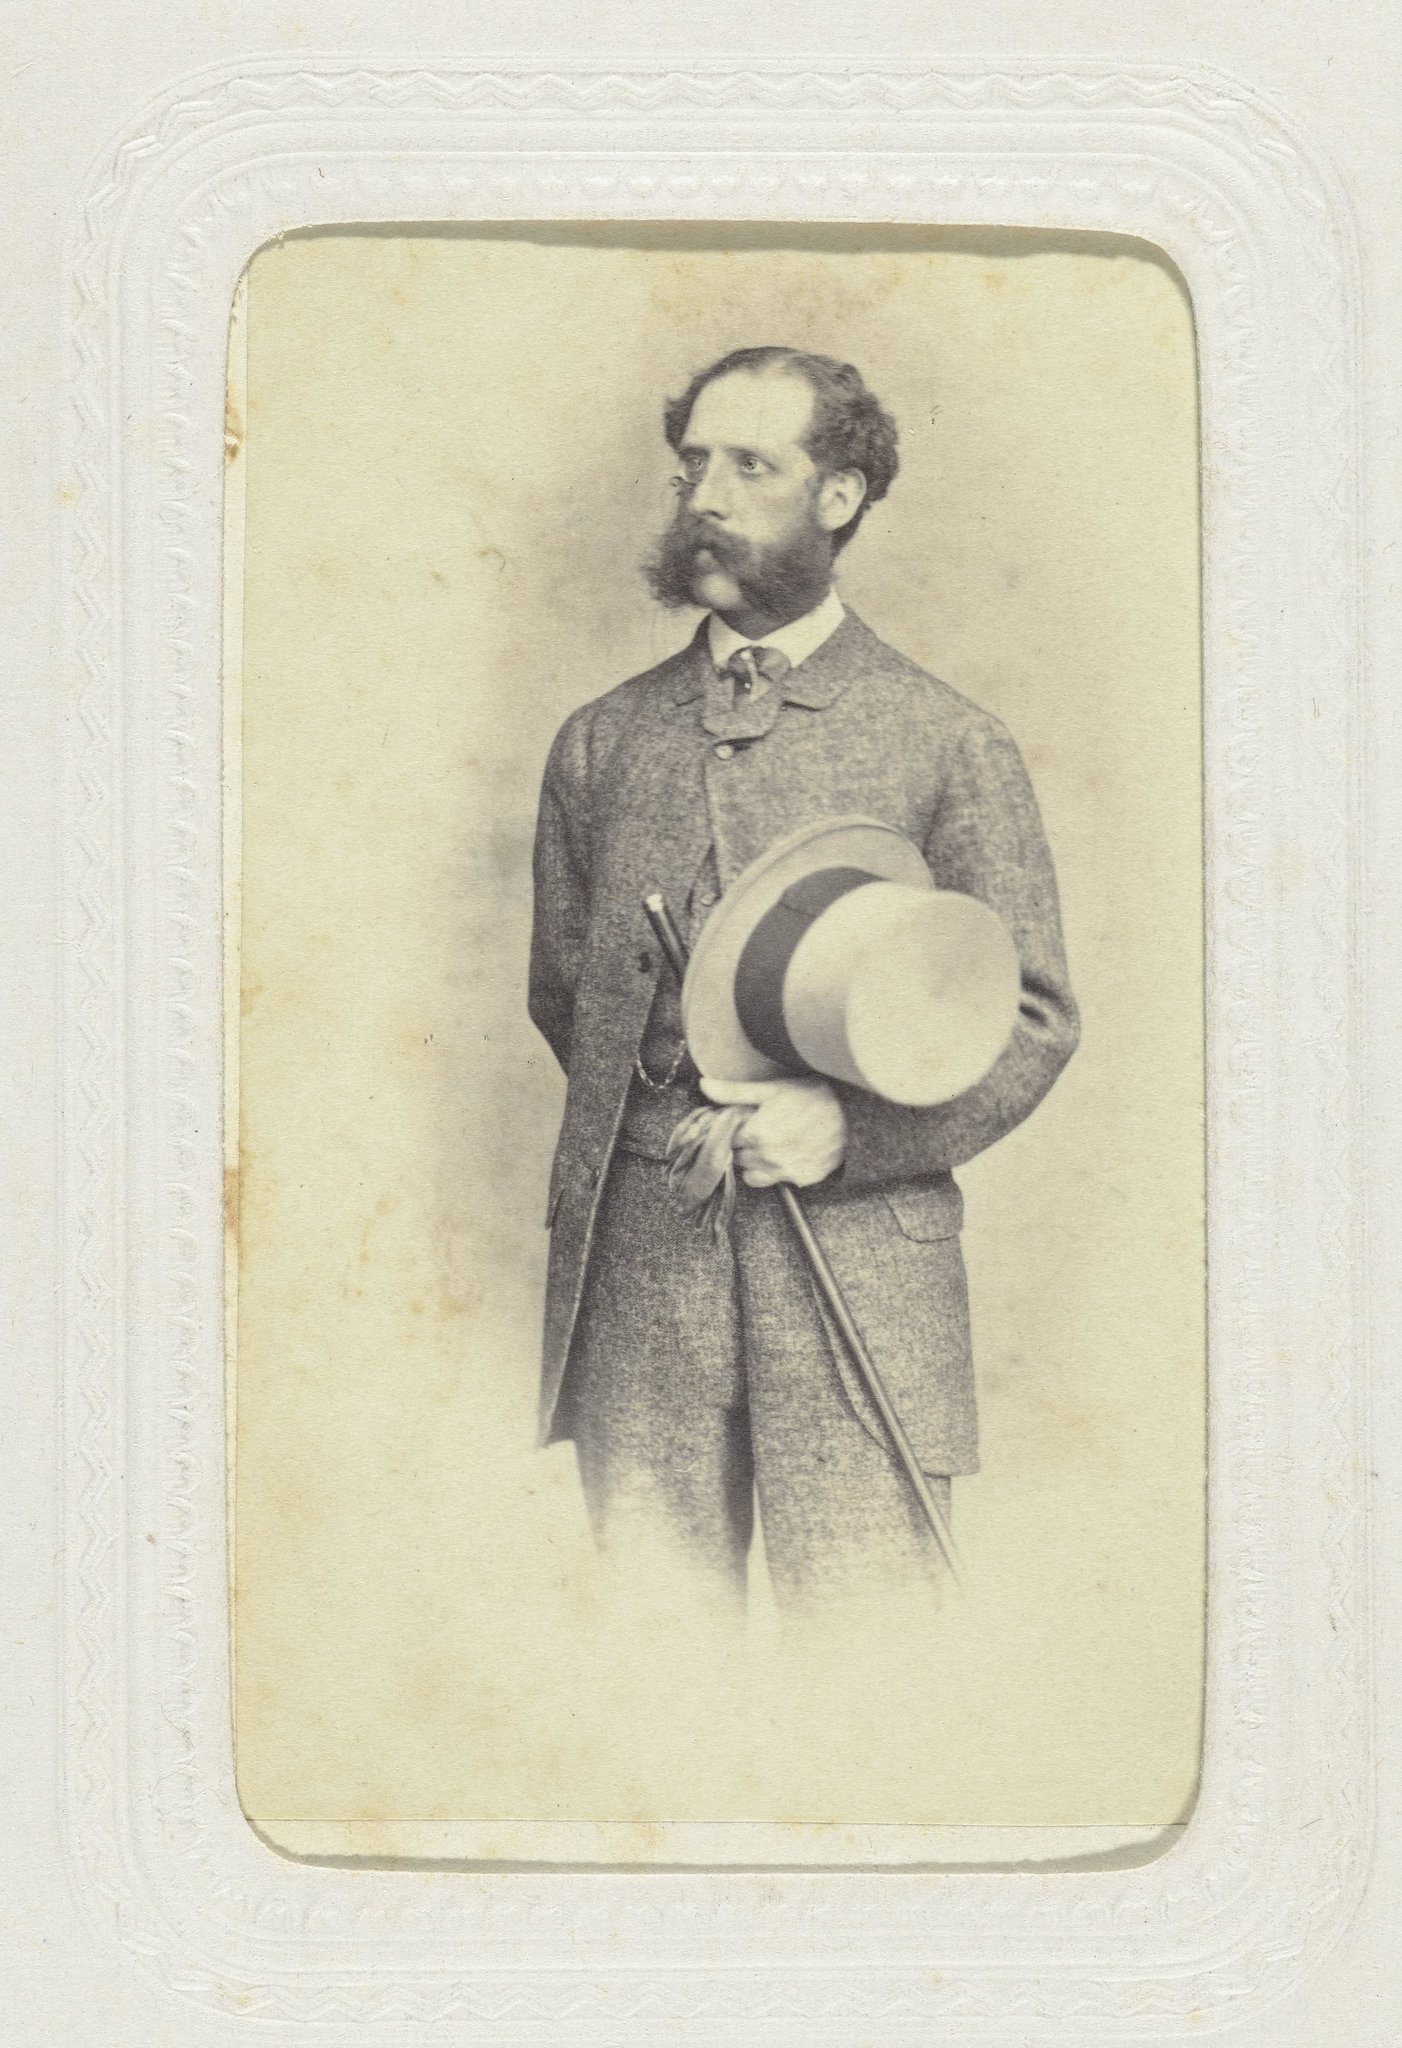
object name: carte de visite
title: Studioportret van een man in kostuum met een wandelstok en handschoenen in zijn hand en een hoge hoed rustend op zijn arm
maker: hermann günter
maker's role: painter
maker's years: -1897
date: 1863-1866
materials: cardboard, paper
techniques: albumen print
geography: amsterdam